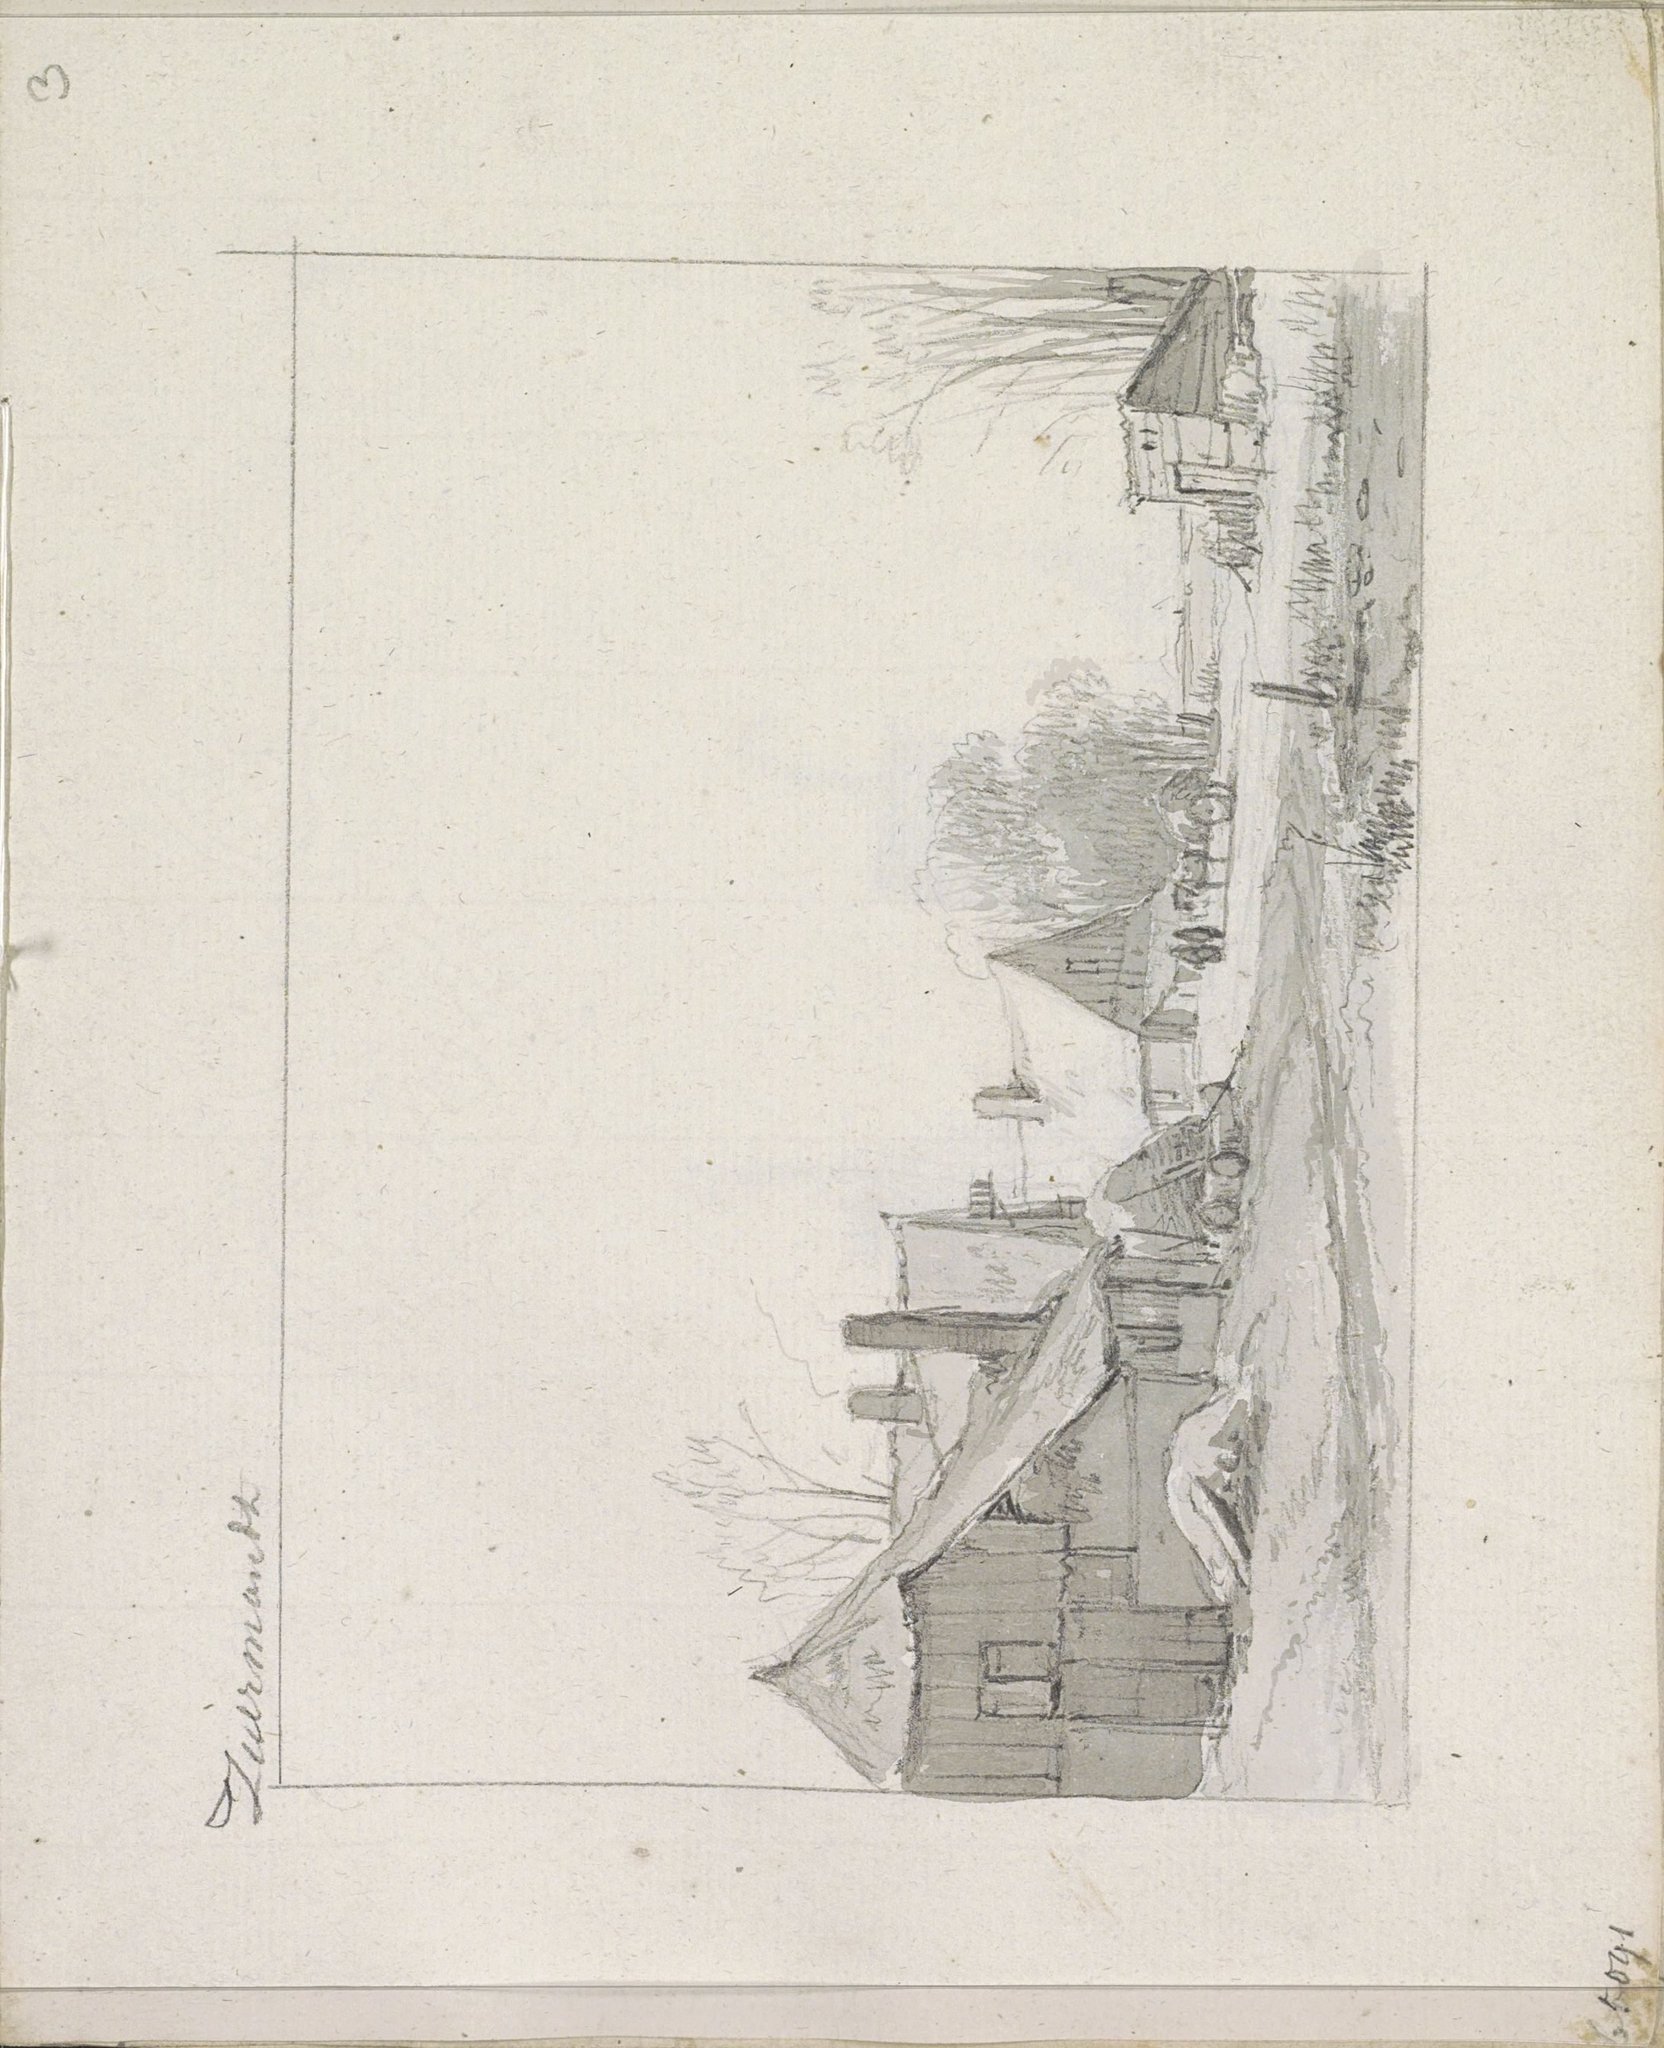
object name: sketchbook leaf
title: Landweg langs boerderijen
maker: andreas schelfhout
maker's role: draughtsman, painter, print maker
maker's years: 1787-1870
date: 1825-1829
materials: paper, pencil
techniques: brush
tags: road, path, farm (building)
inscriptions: number: ‘3/ 66091’, annotation: ‘Z[...]erma[...]’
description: Blad 7 recto uit een schetsboek met 95 bladen.